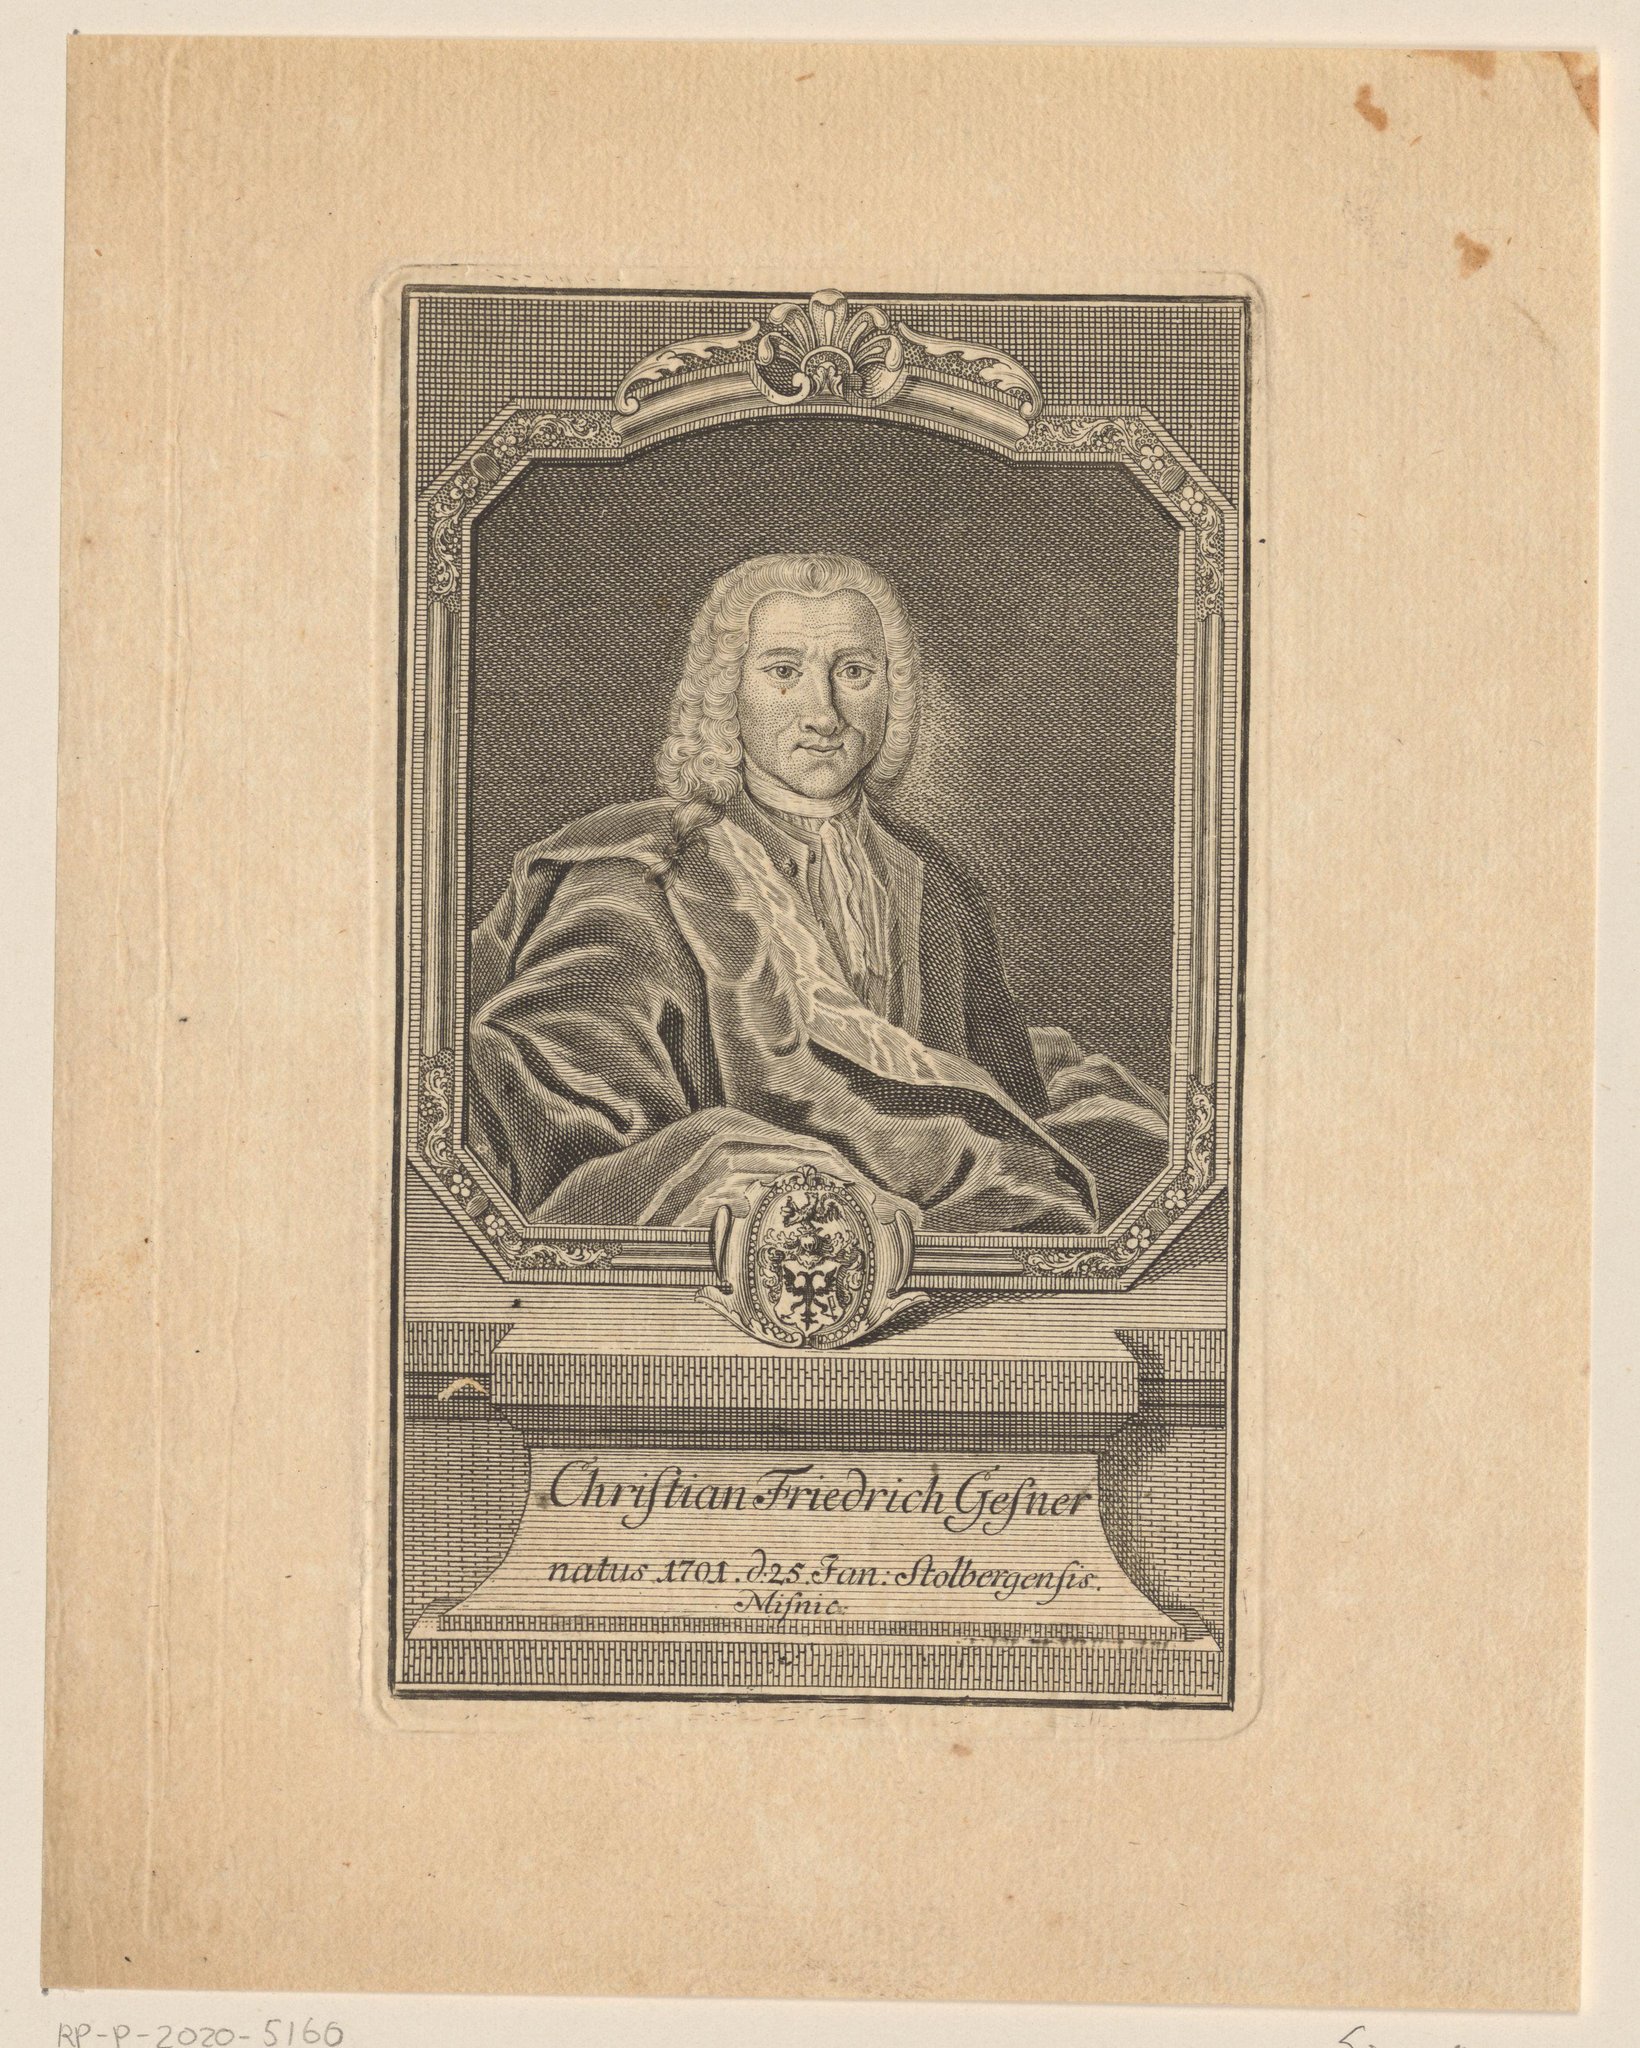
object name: print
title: Portret van Christian Friedrich Gessner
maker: Anonymous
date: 1710-1756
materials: paper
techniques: engraving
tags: printer, publisher, theologian, historical persons